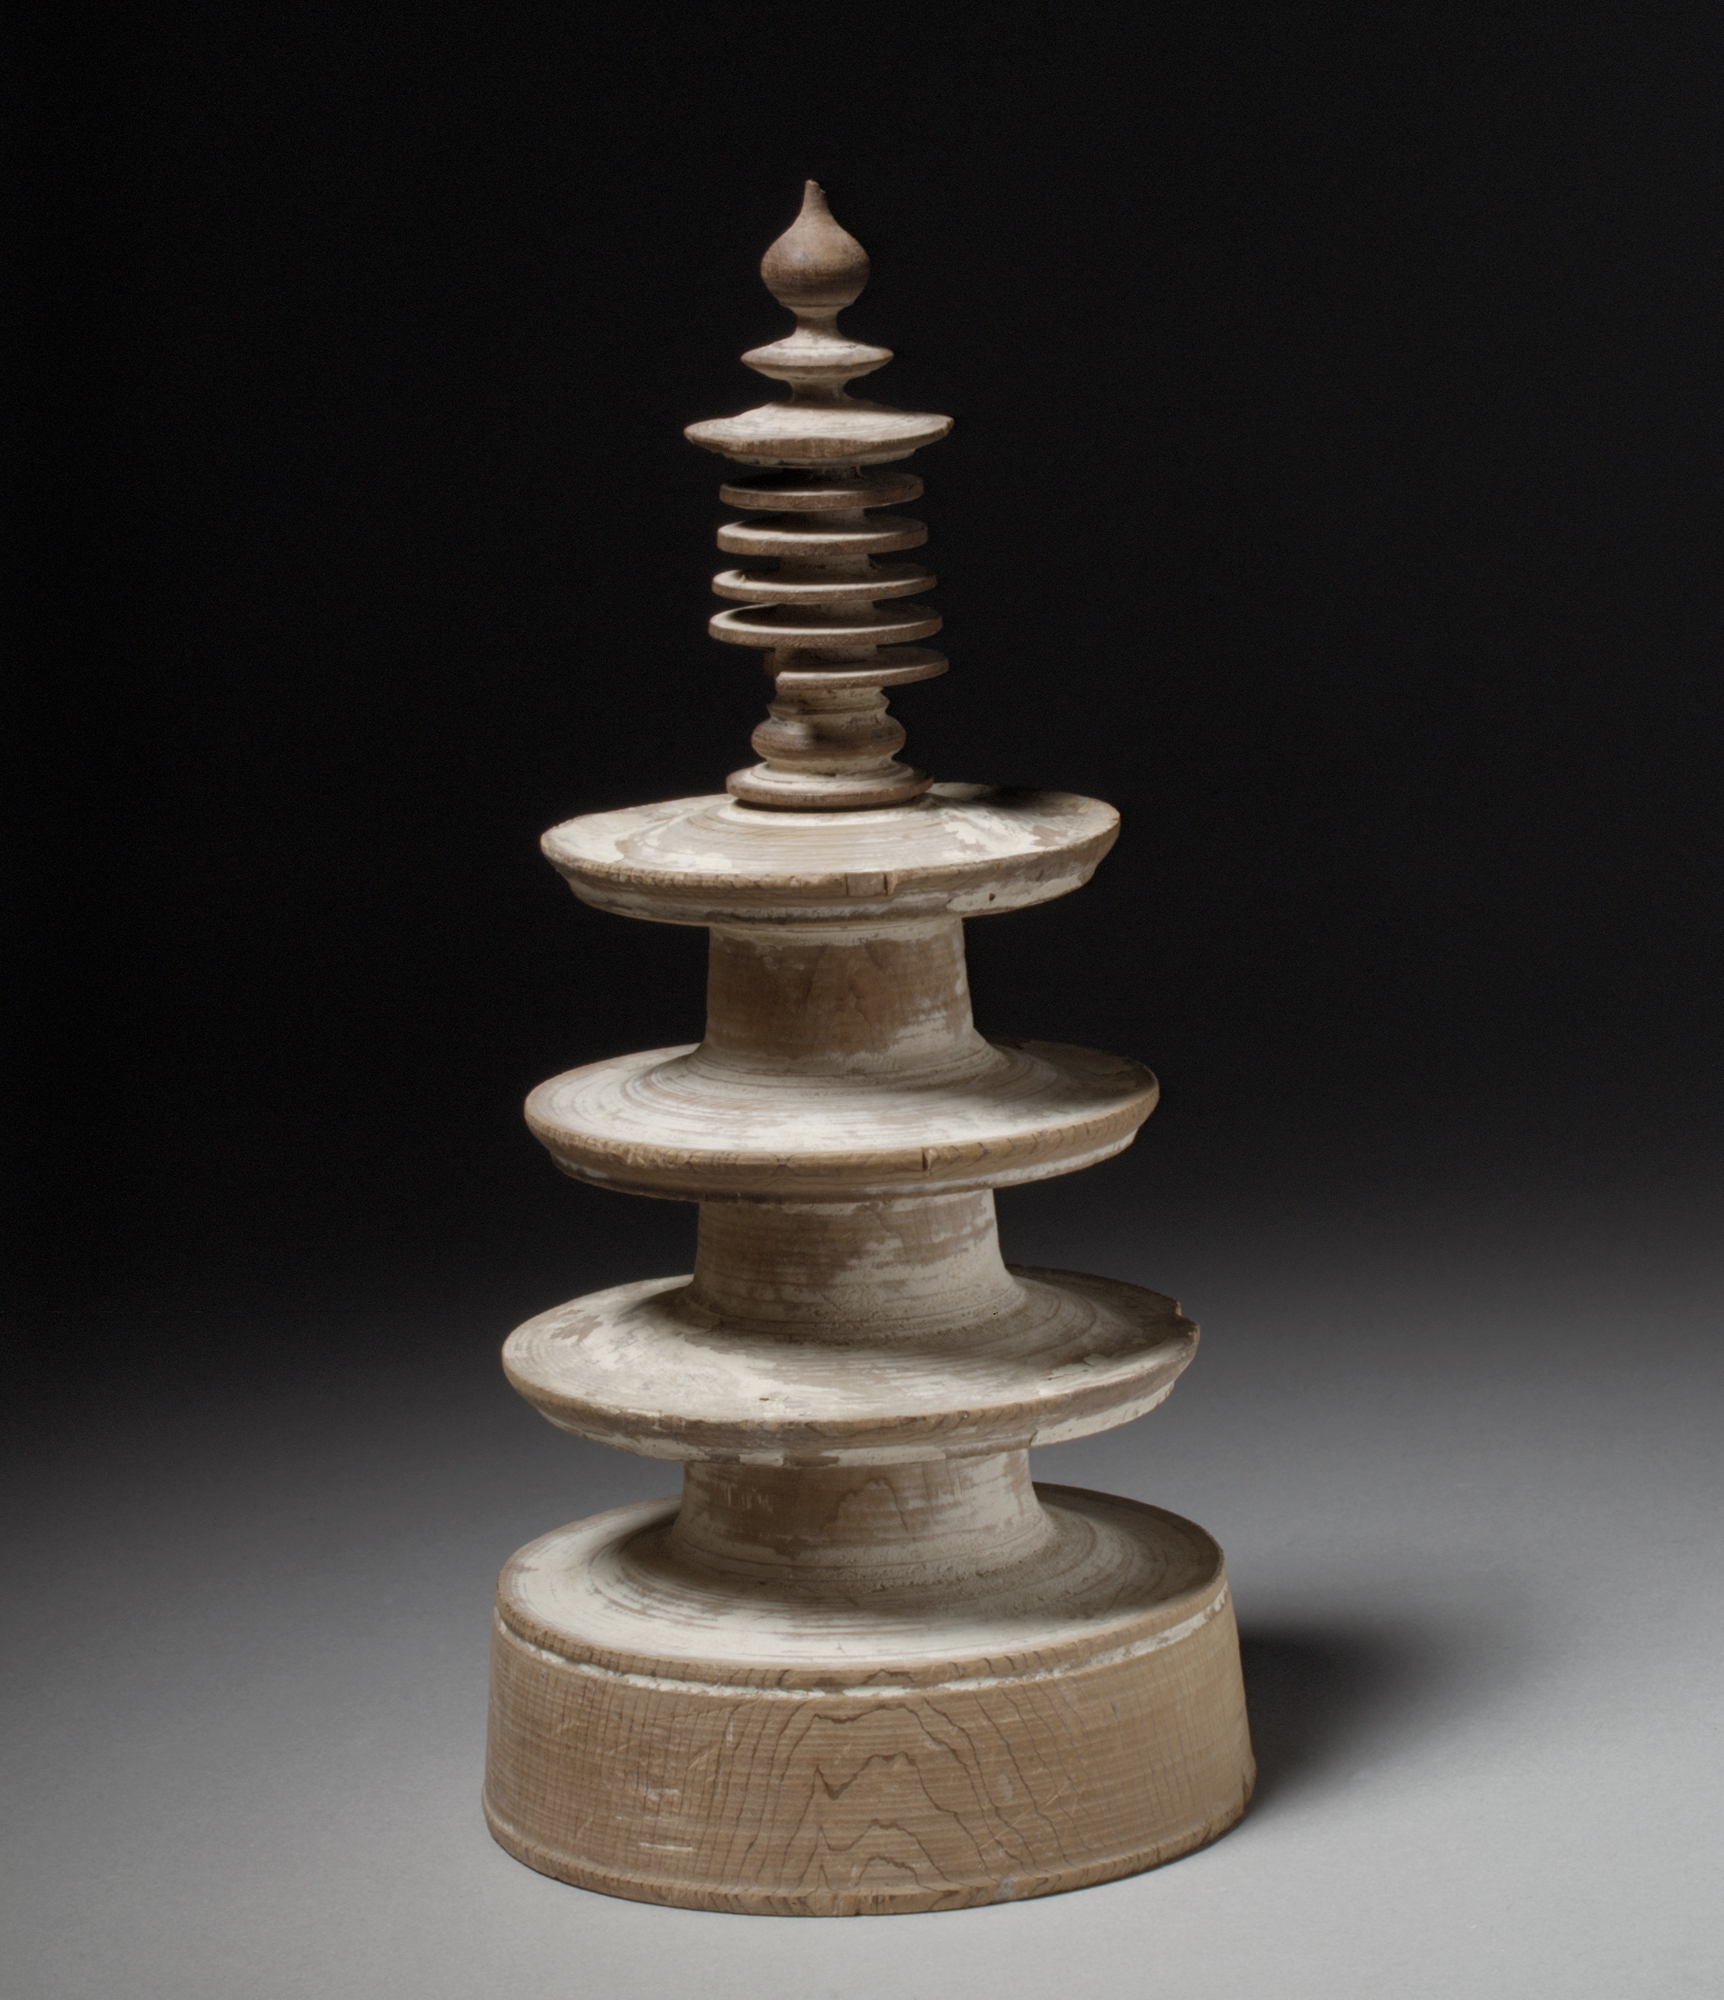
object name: pagoda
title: One of the “One Million Pagodas” (Hyakumanto)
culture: japanese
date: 764-770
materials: wood, ink, paper